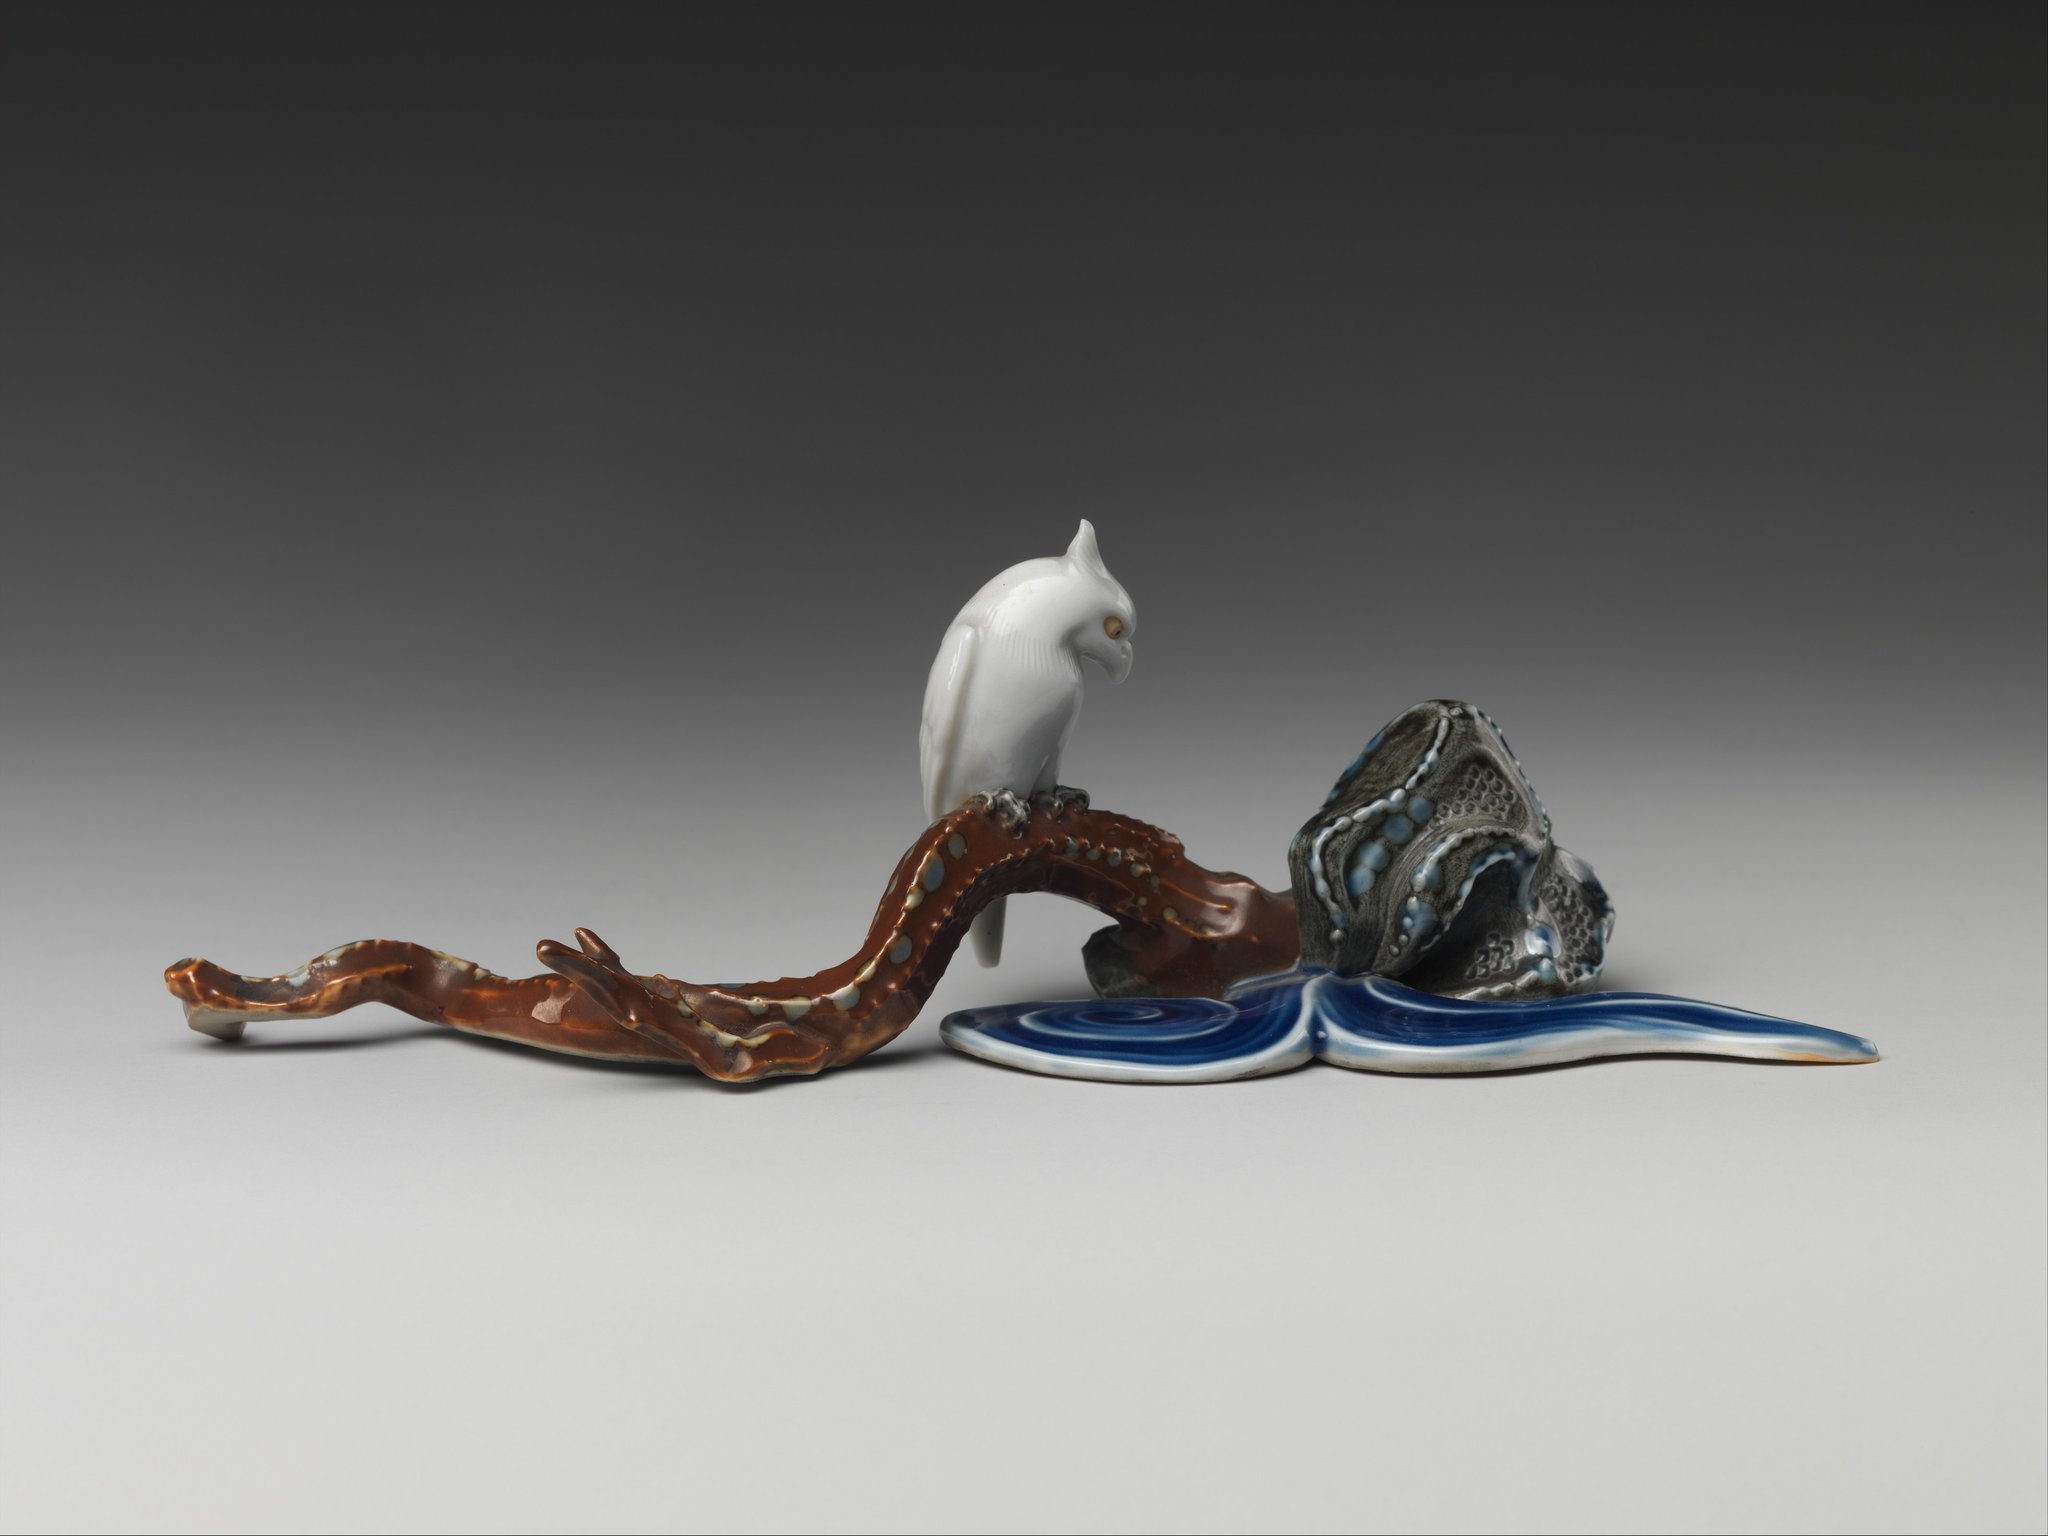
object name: brush rest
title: Brush Rest with White Cockatoo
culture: japanese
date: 1734-1766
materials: enamel, porcelain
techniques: overglaze, underglaze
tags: birds